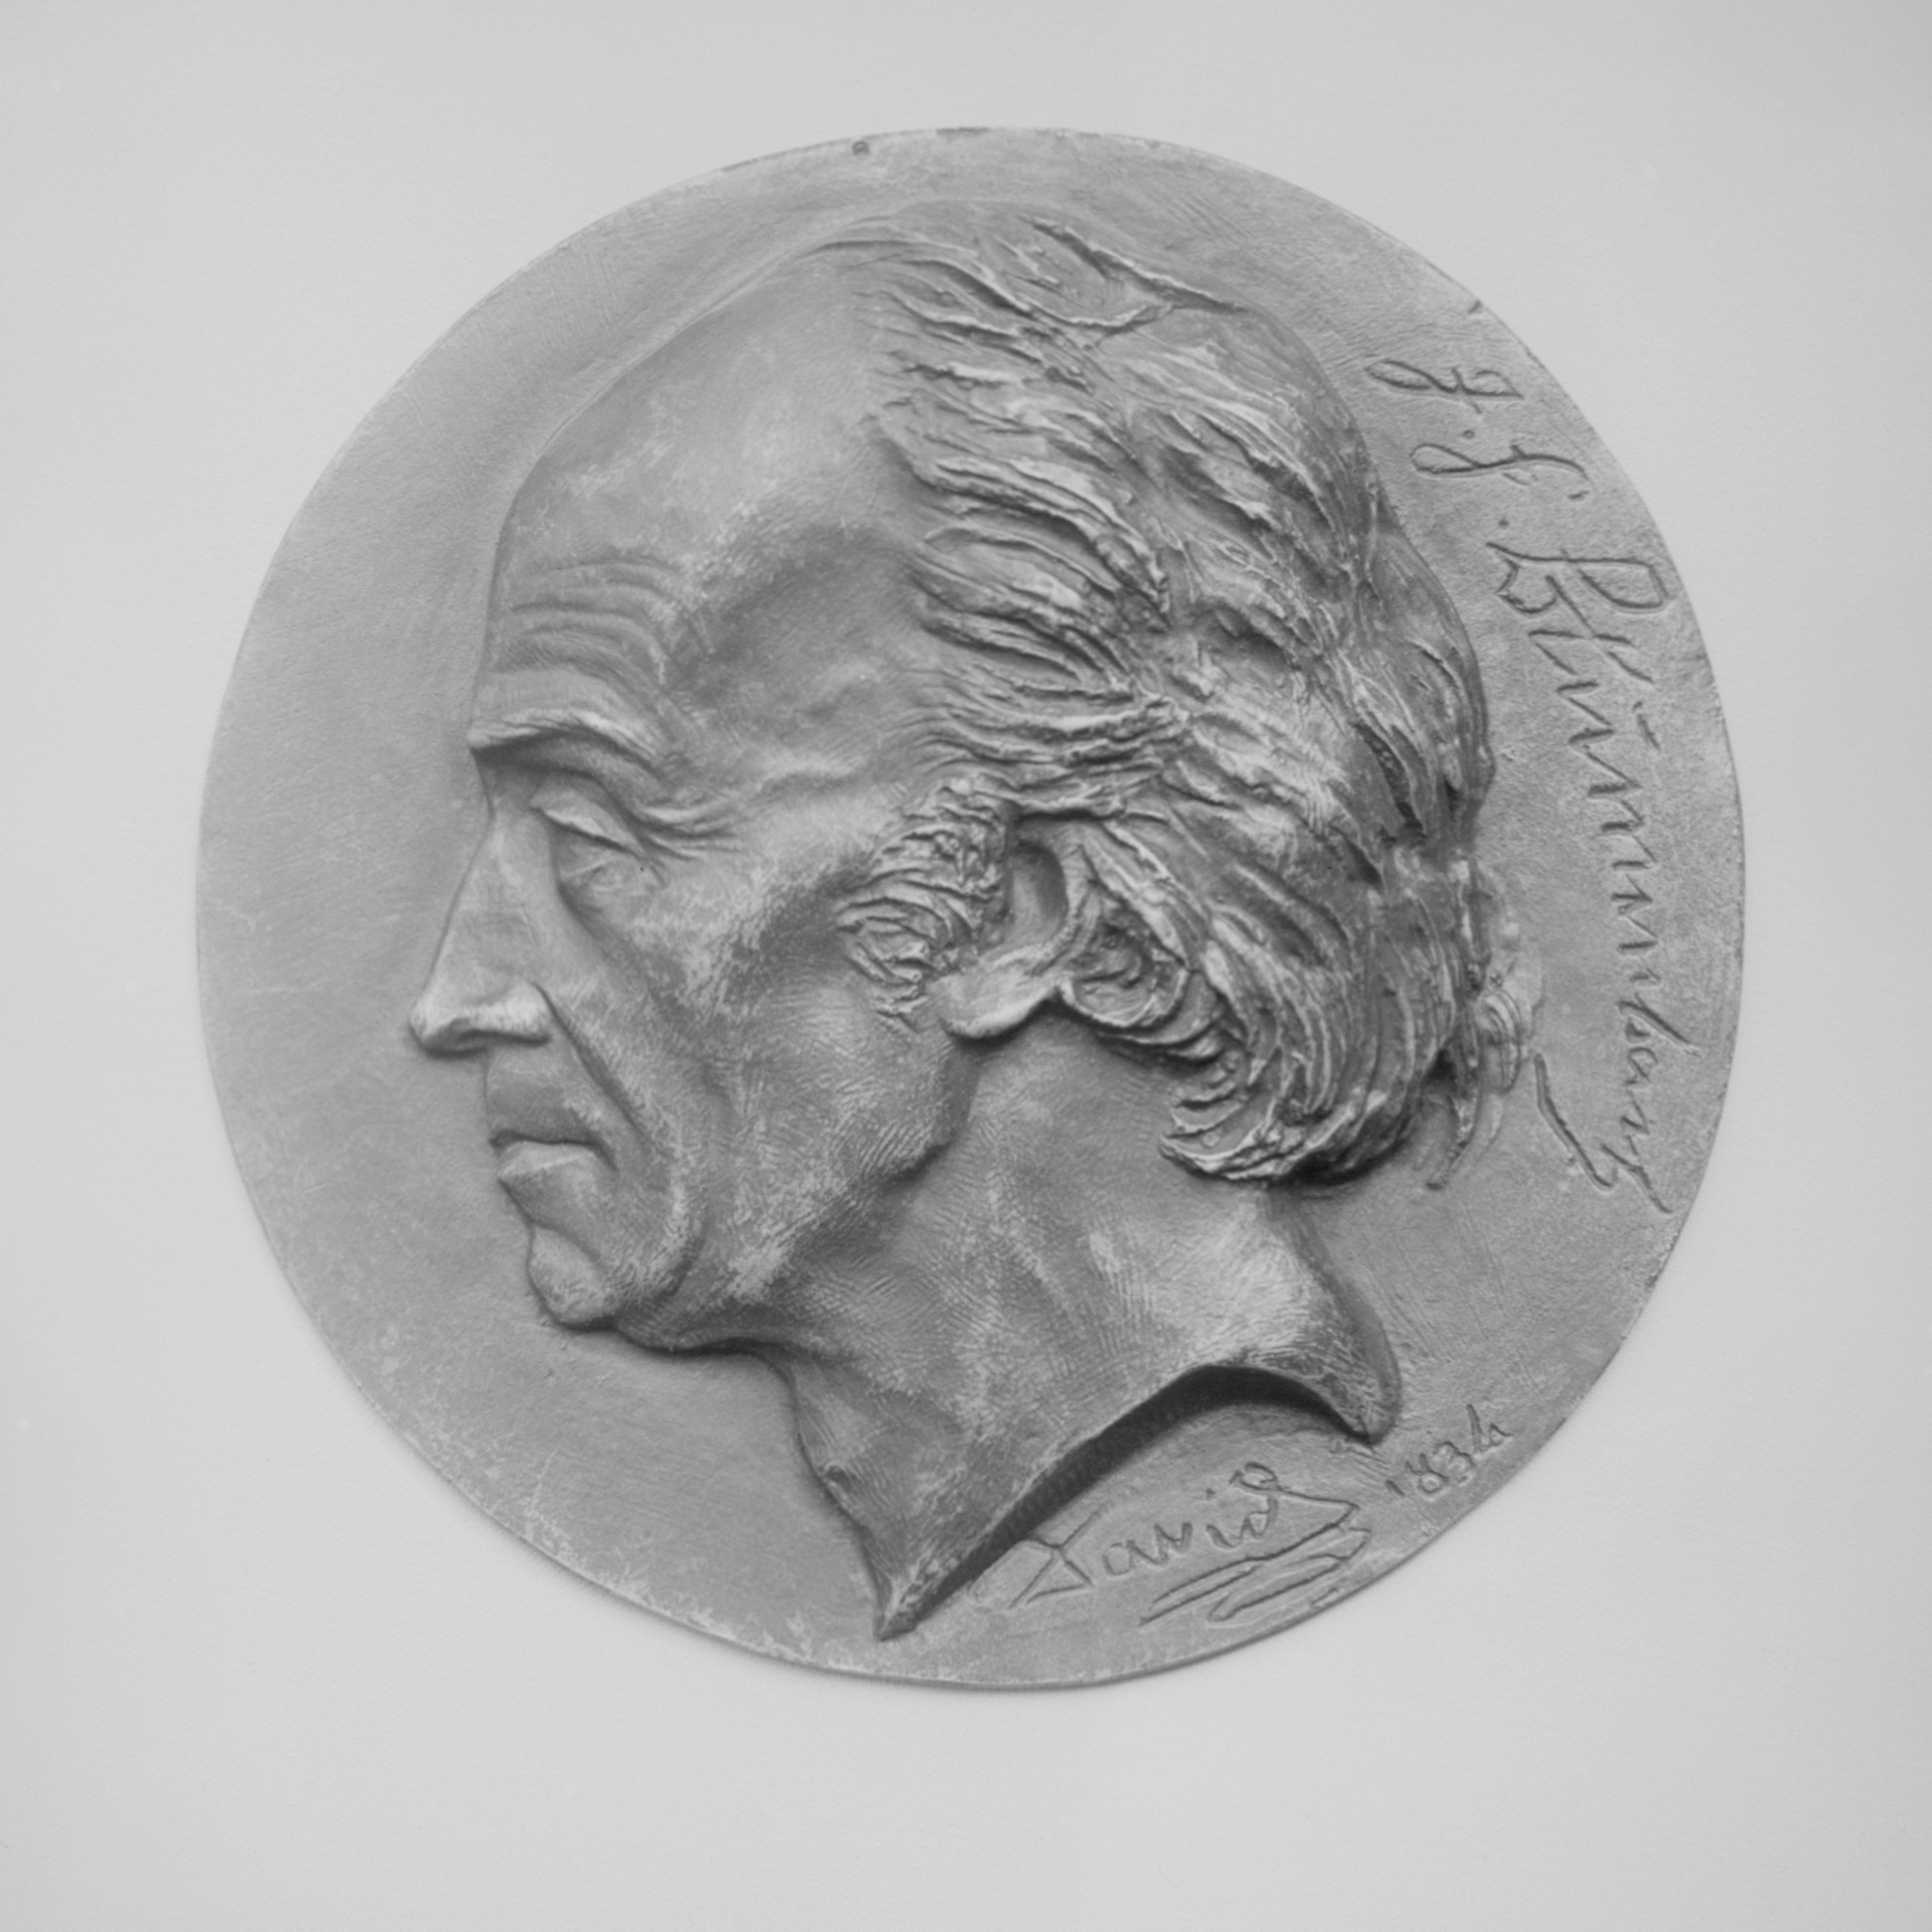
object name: medallion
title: John Frederick Blumenbach (1752–1841), German physician and physiologist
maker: pierre jean david d'angers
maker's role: artist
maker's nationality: french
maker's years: 1788-1856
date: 1834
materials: bronze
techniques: casting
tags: men,profiles